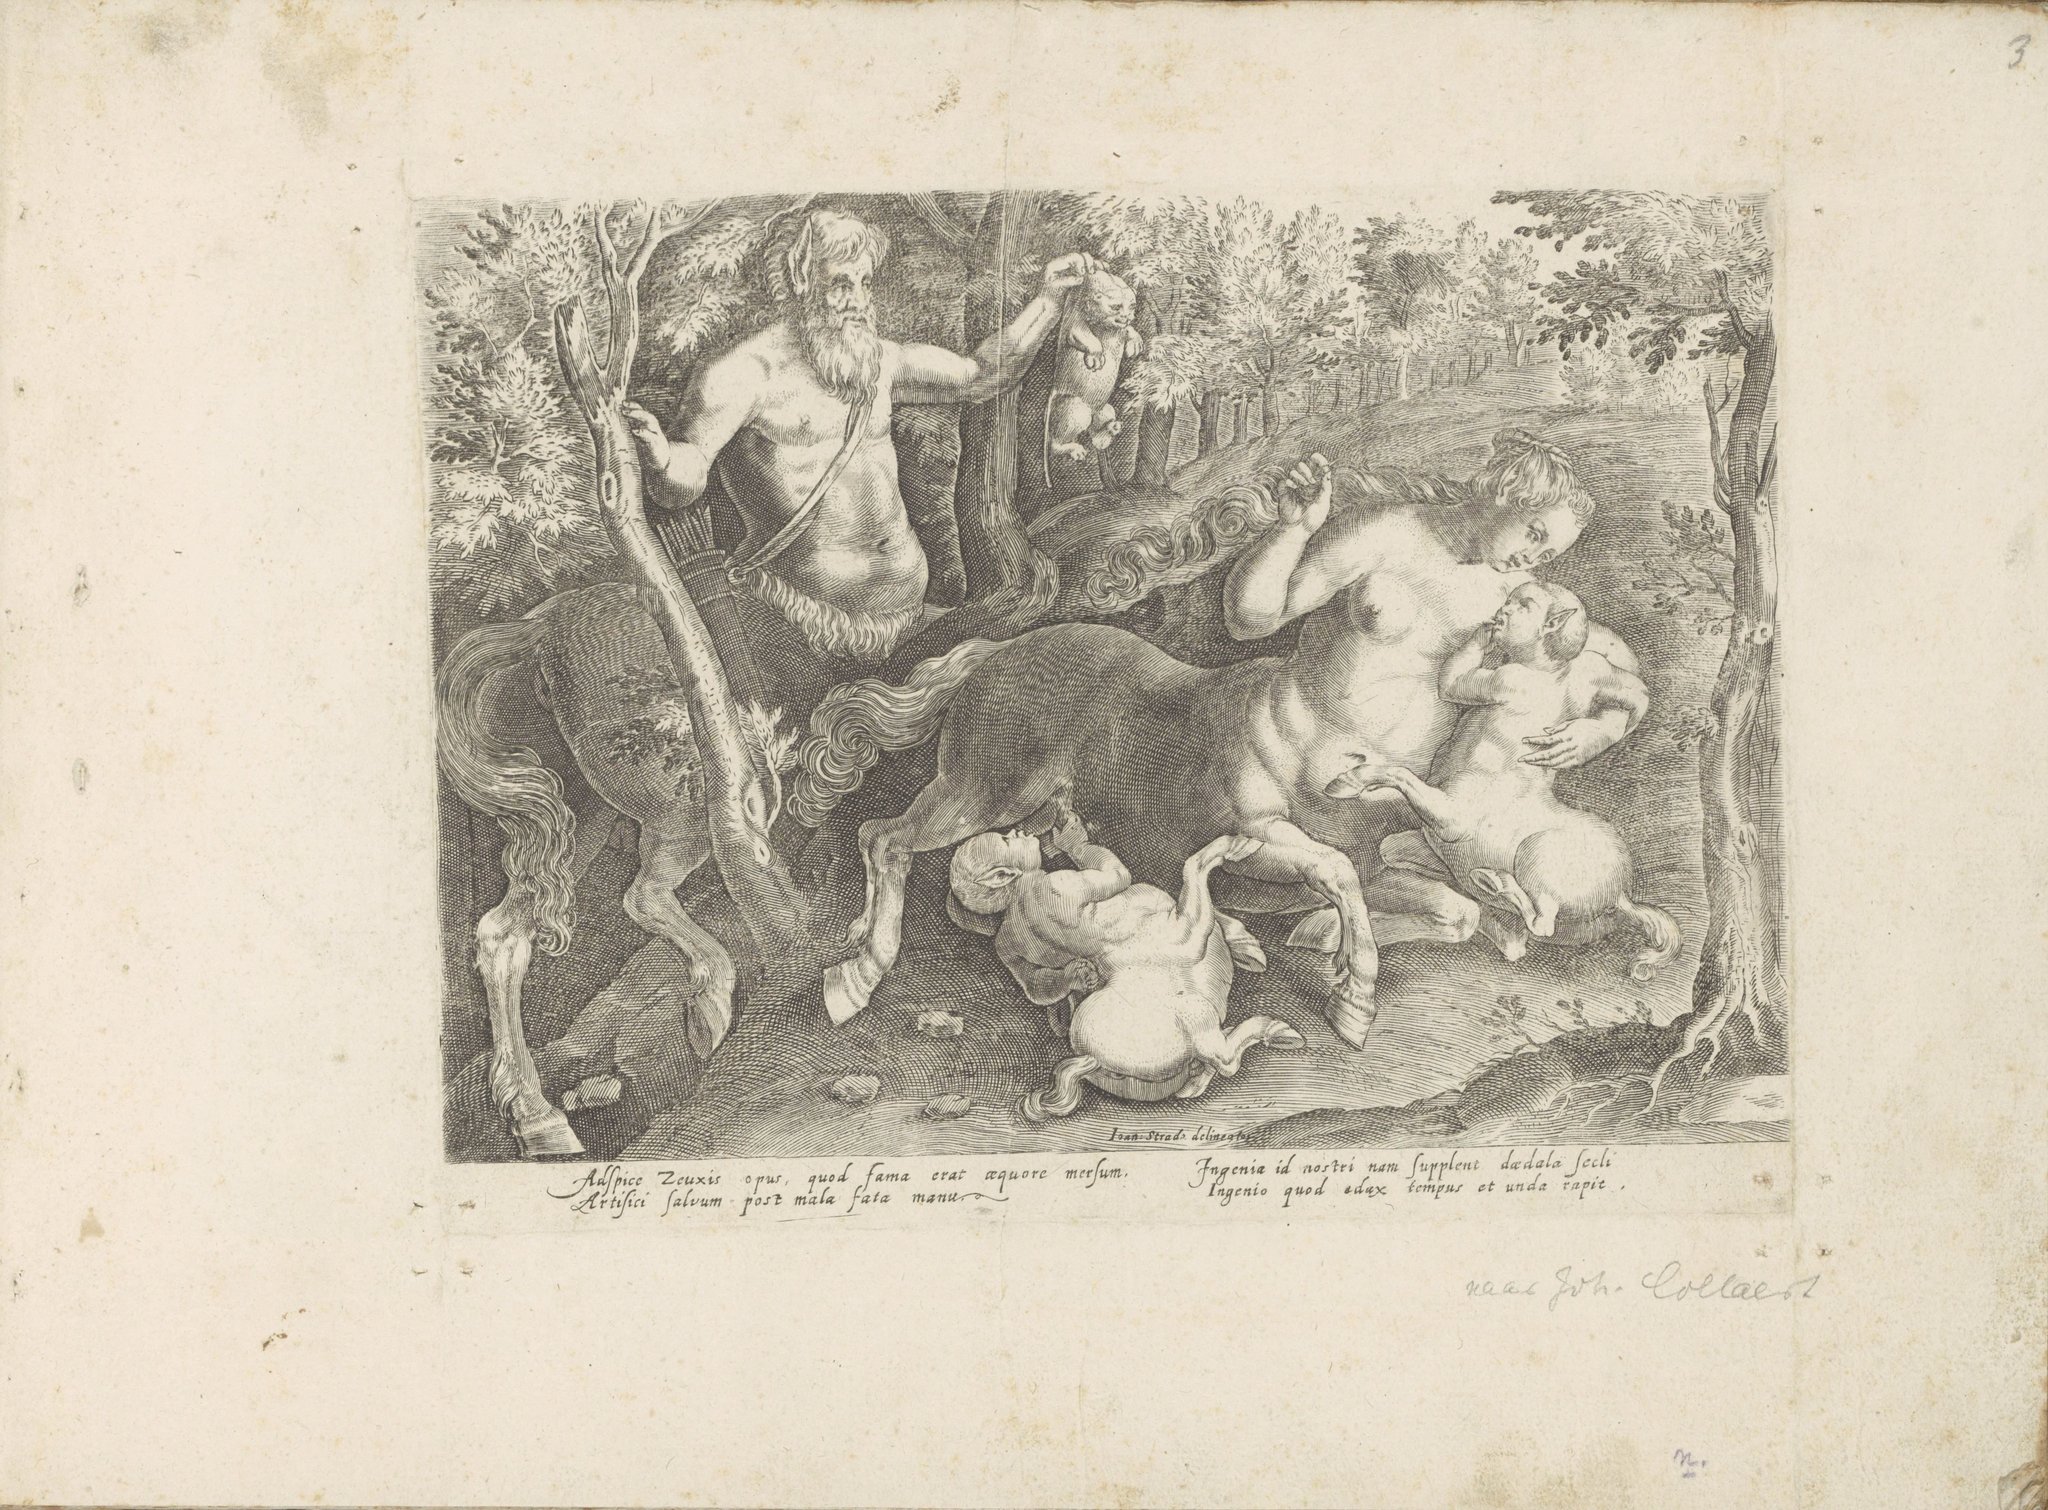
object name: print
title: Centaur familie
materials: paper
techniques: engraving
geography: venice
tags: don juan van oostenrijk, centaurs, feeding a baby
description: Een vrouwelijke centaur voedt haar twee jongen. De mannelijke centaur toont een katachtige, die hij bij het nekvel vasthoudt. Prent maakt deel uit van een album.